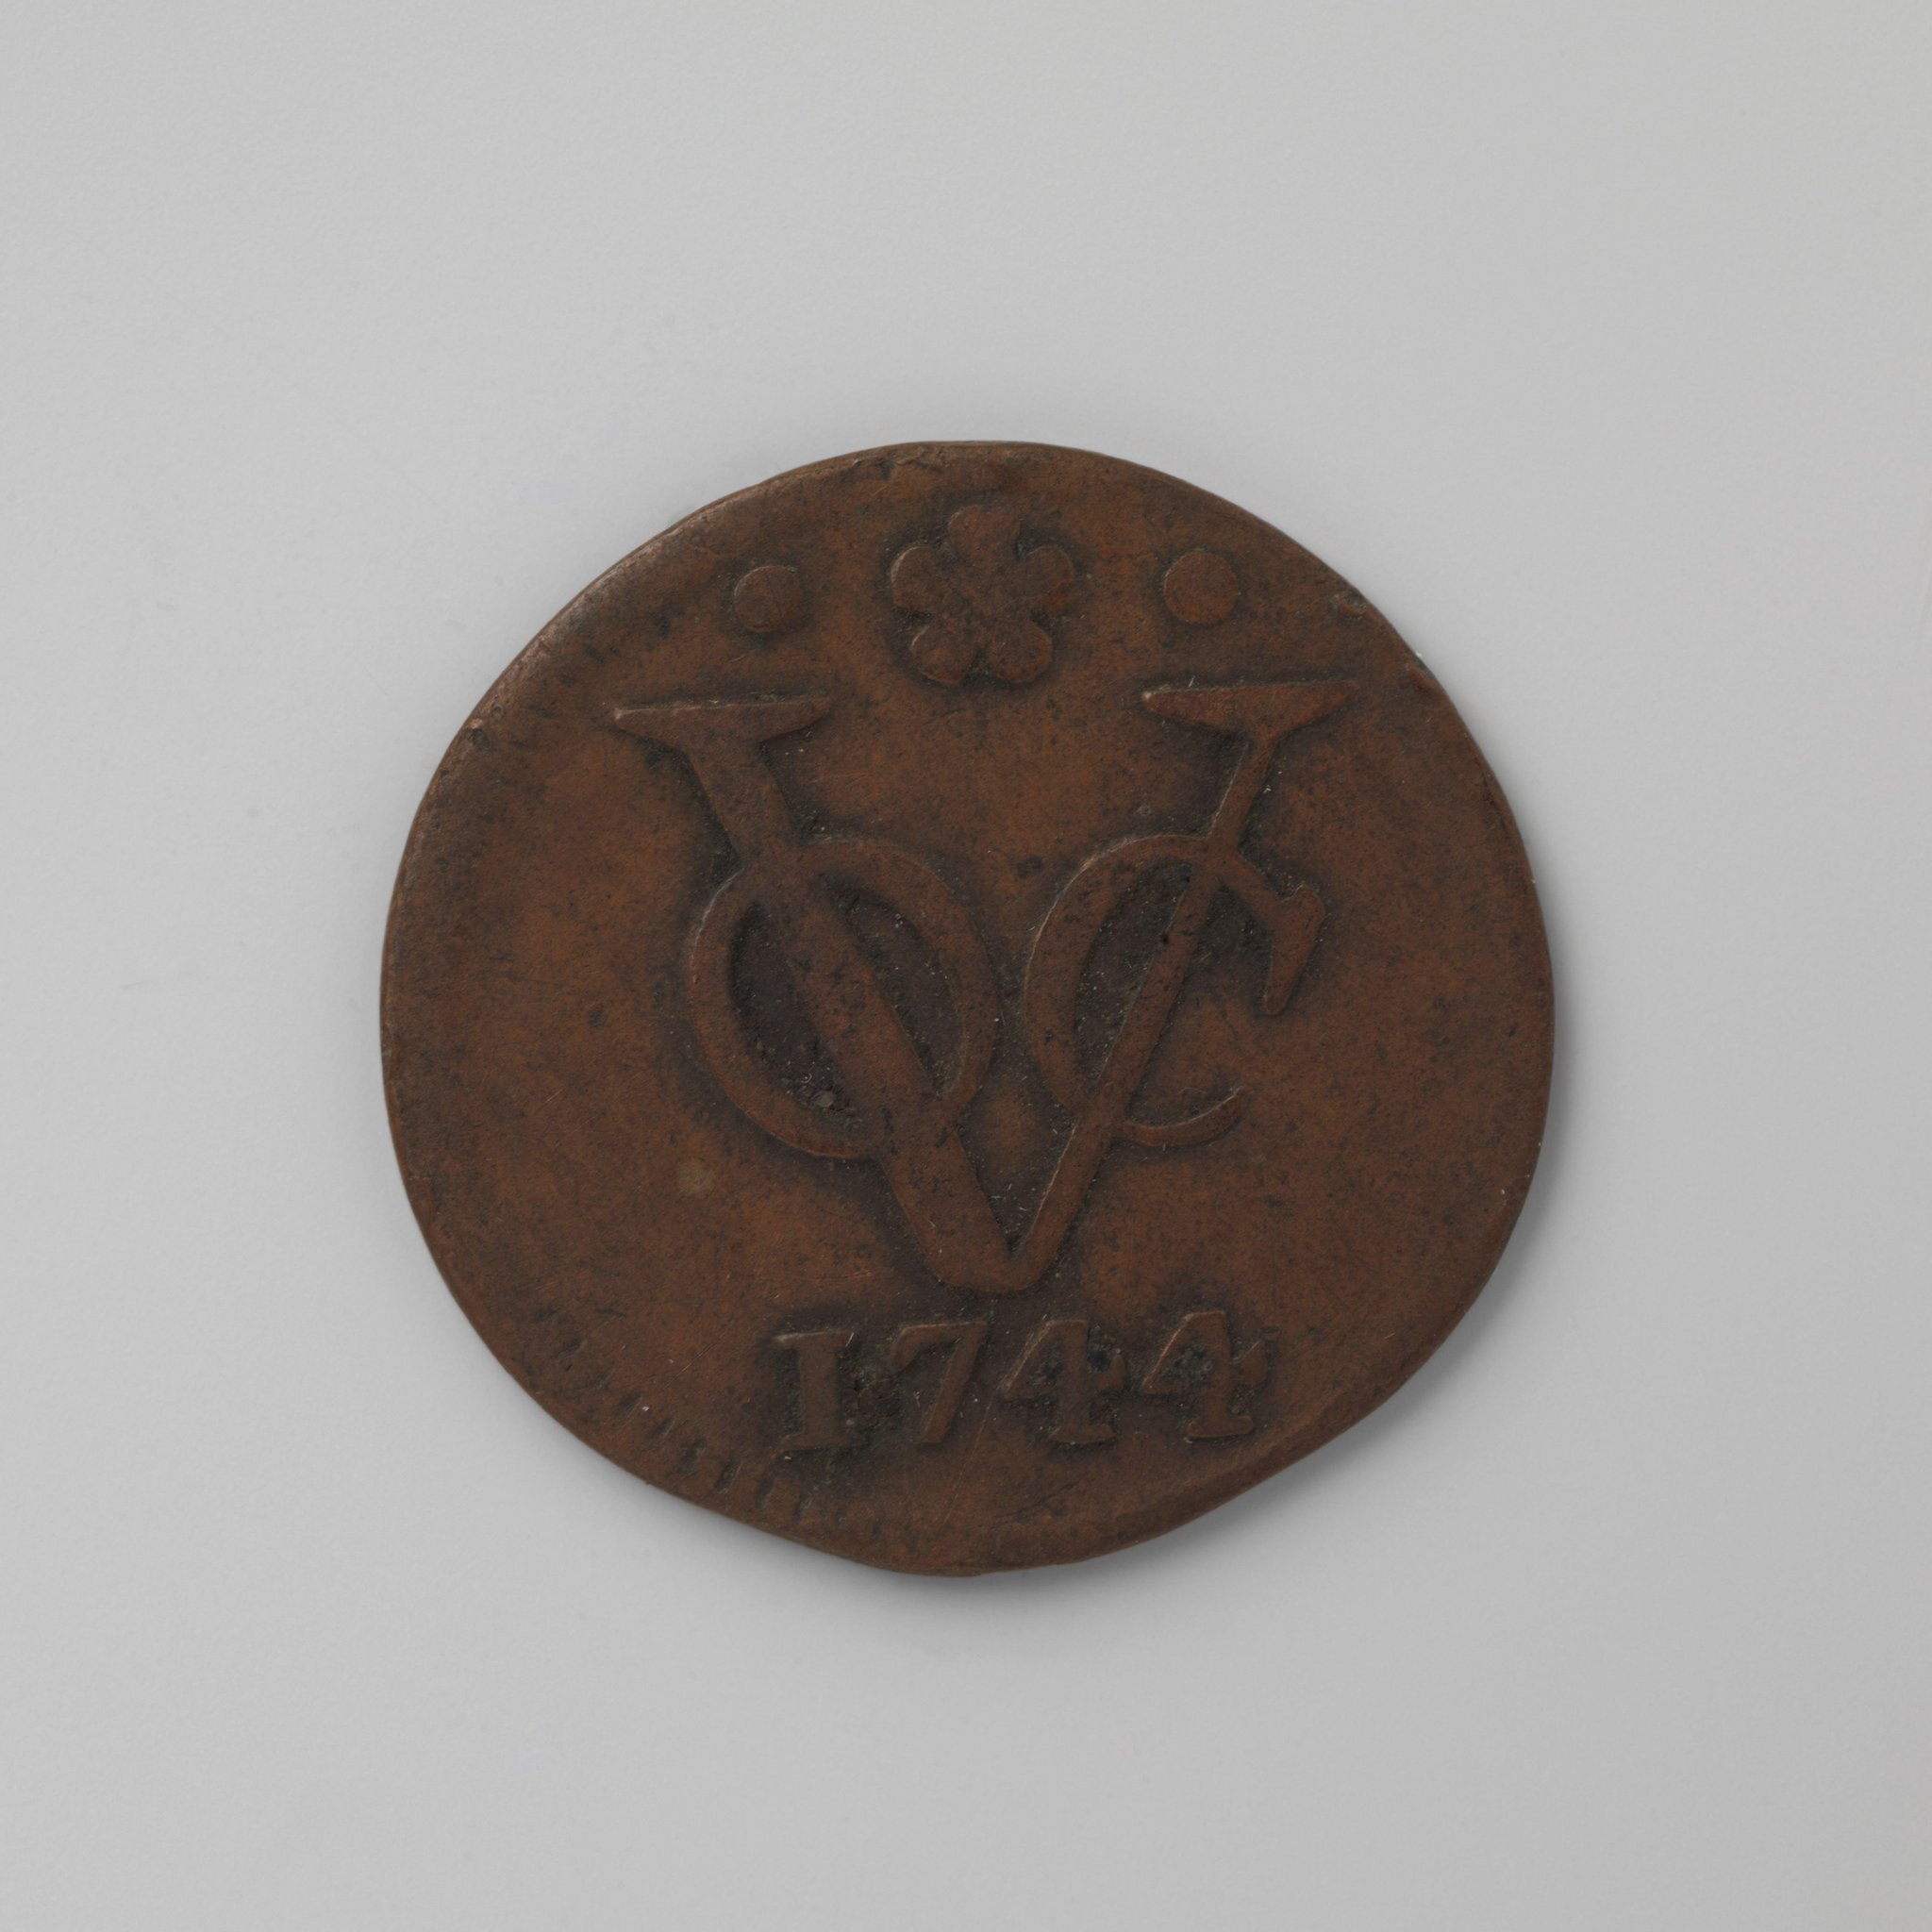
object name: coin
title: VOC, duit Holland, 1744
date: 1744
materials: copper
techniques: striking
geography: dordrecht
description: Koperen munt. Voorzijde: gekroond wapenschild van Holland. Keerzijde: monogram van de VOC, waarboven muntteken en waaronder jaartal. Gladde rand.